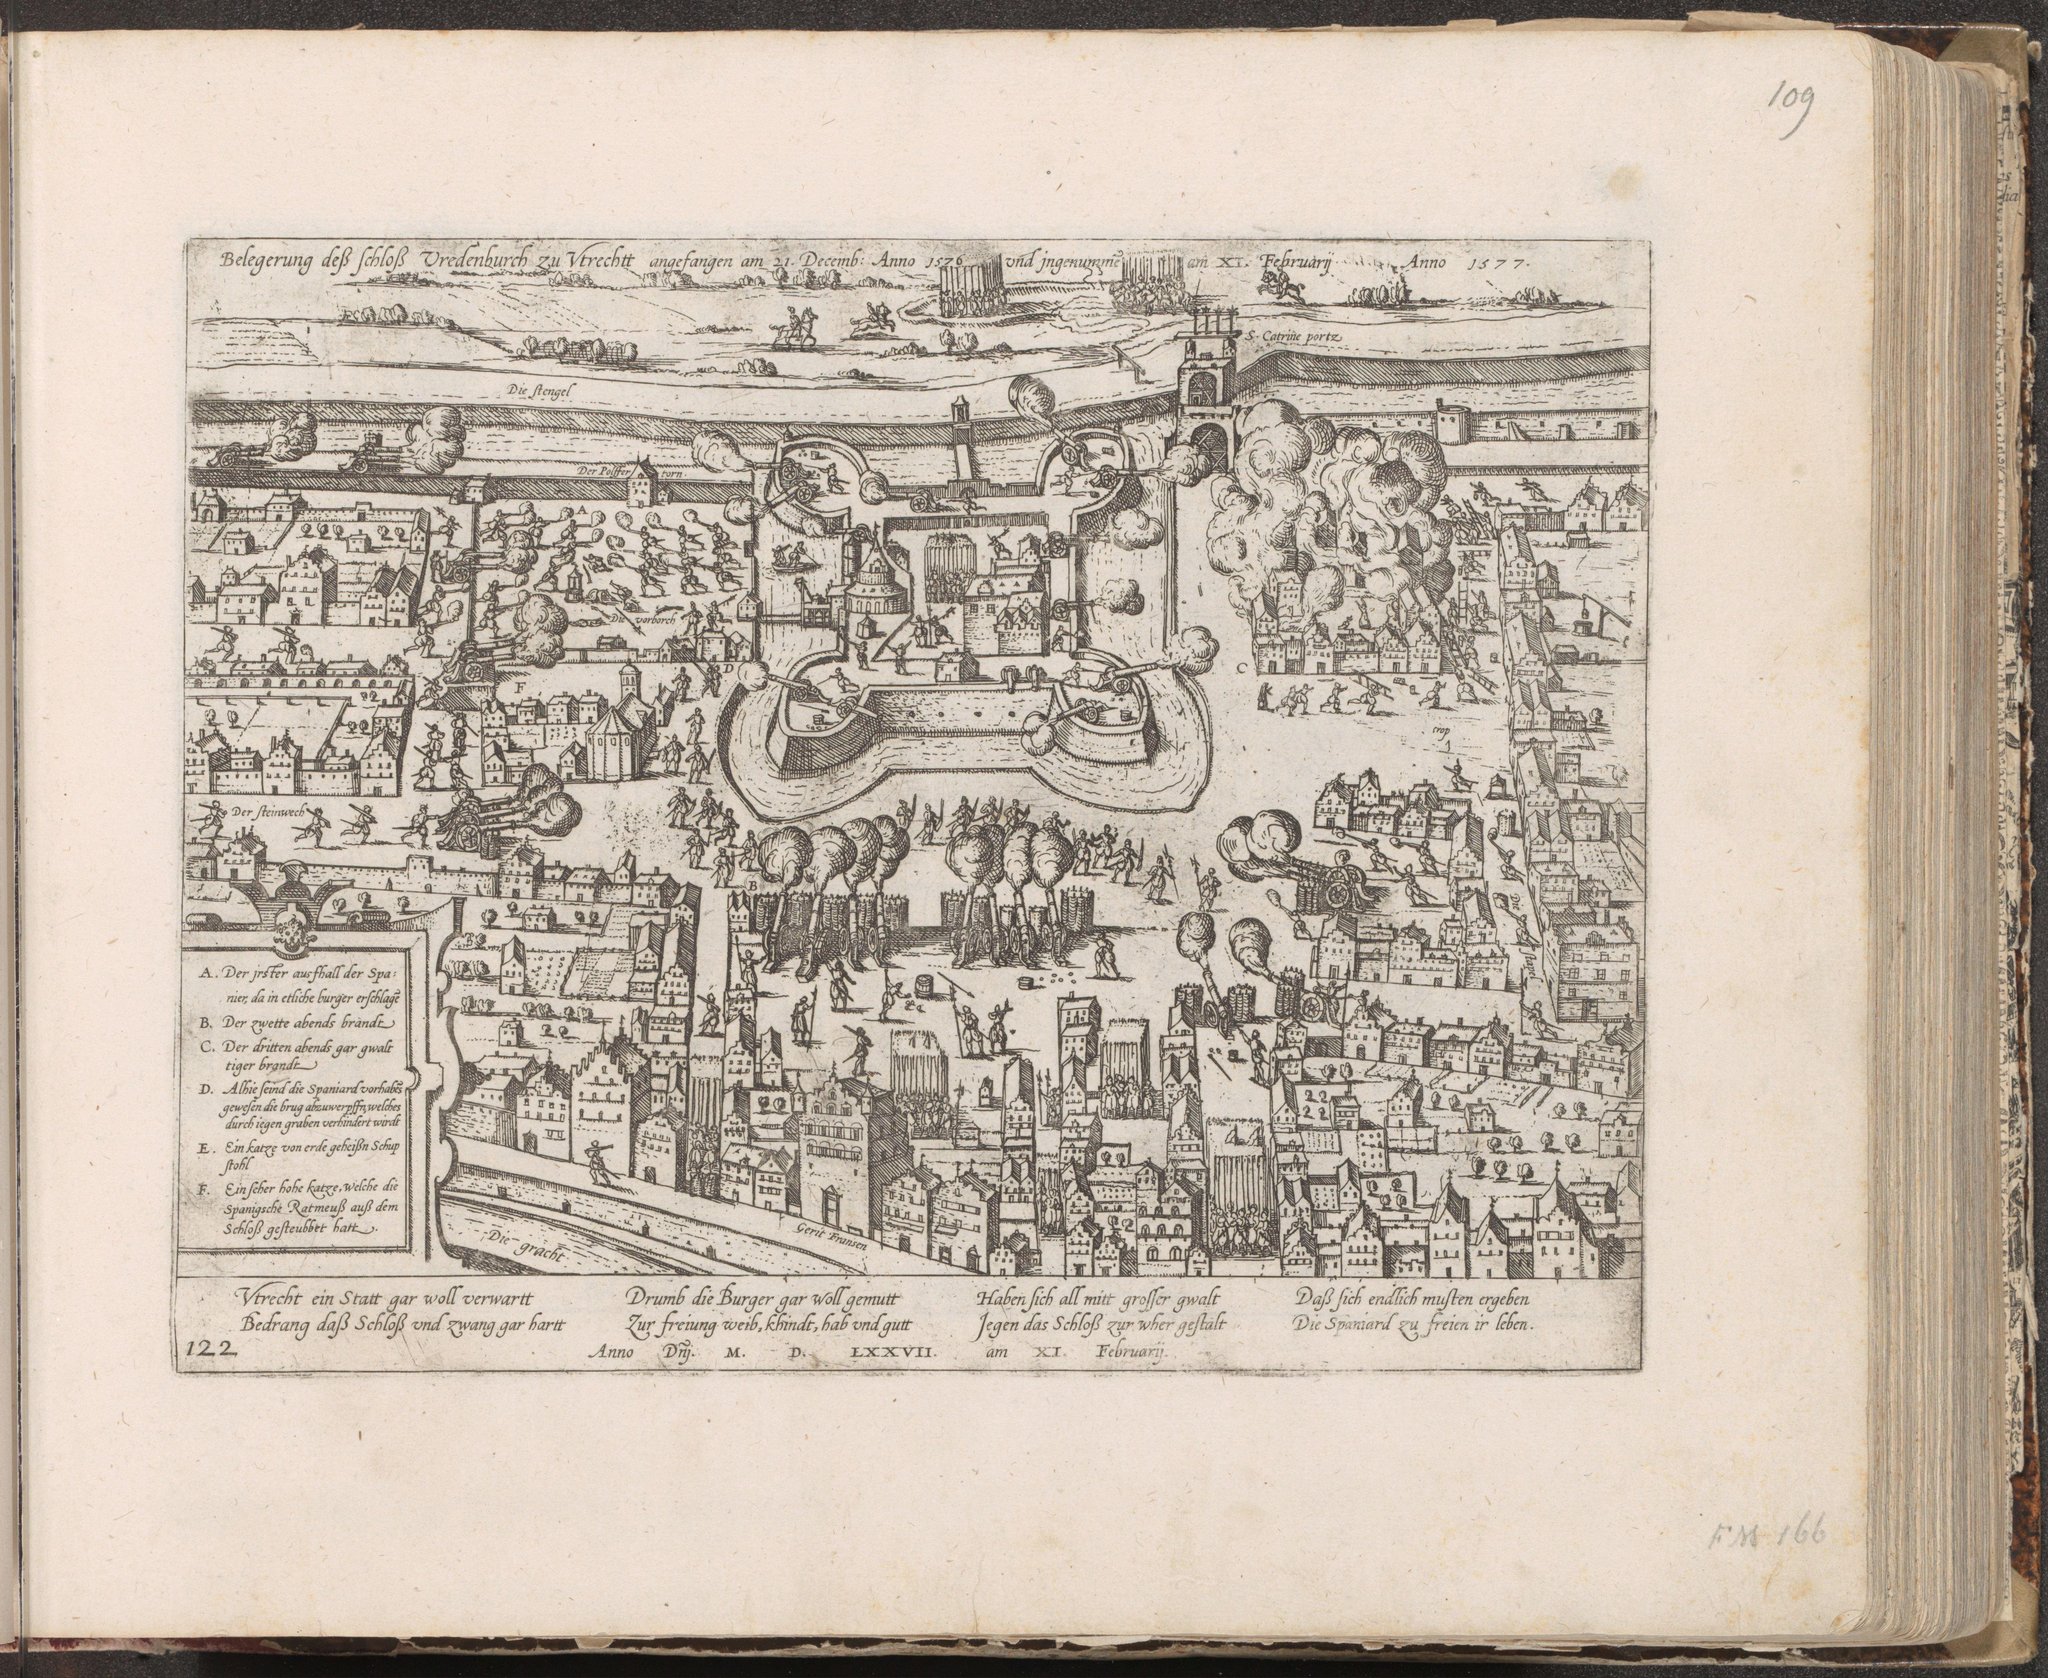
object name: history print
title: Serie 7: Nederlandse Gebeurtenissen, 1576-1577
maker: frans hogenberg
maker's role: print maker, publisher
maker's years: 1538-1590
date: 1577-1579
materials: paper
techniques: etching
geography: cologne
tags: siege, position war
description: Beleg en inname van het slot Vredenburg te Utrecht door het Staatse leger onder bevel van Bossu, 11 februari 1577. Gezicht op het fort en de omliggende straten met de diverse schermutselingen. Links een legenda A-F van de belangrijkste gebeurtenissen tijdens de strijd. Met onderschrift van 8 regels in het Duits. Linksonder genummerd: 122. De prent maakt deel uit van een album.